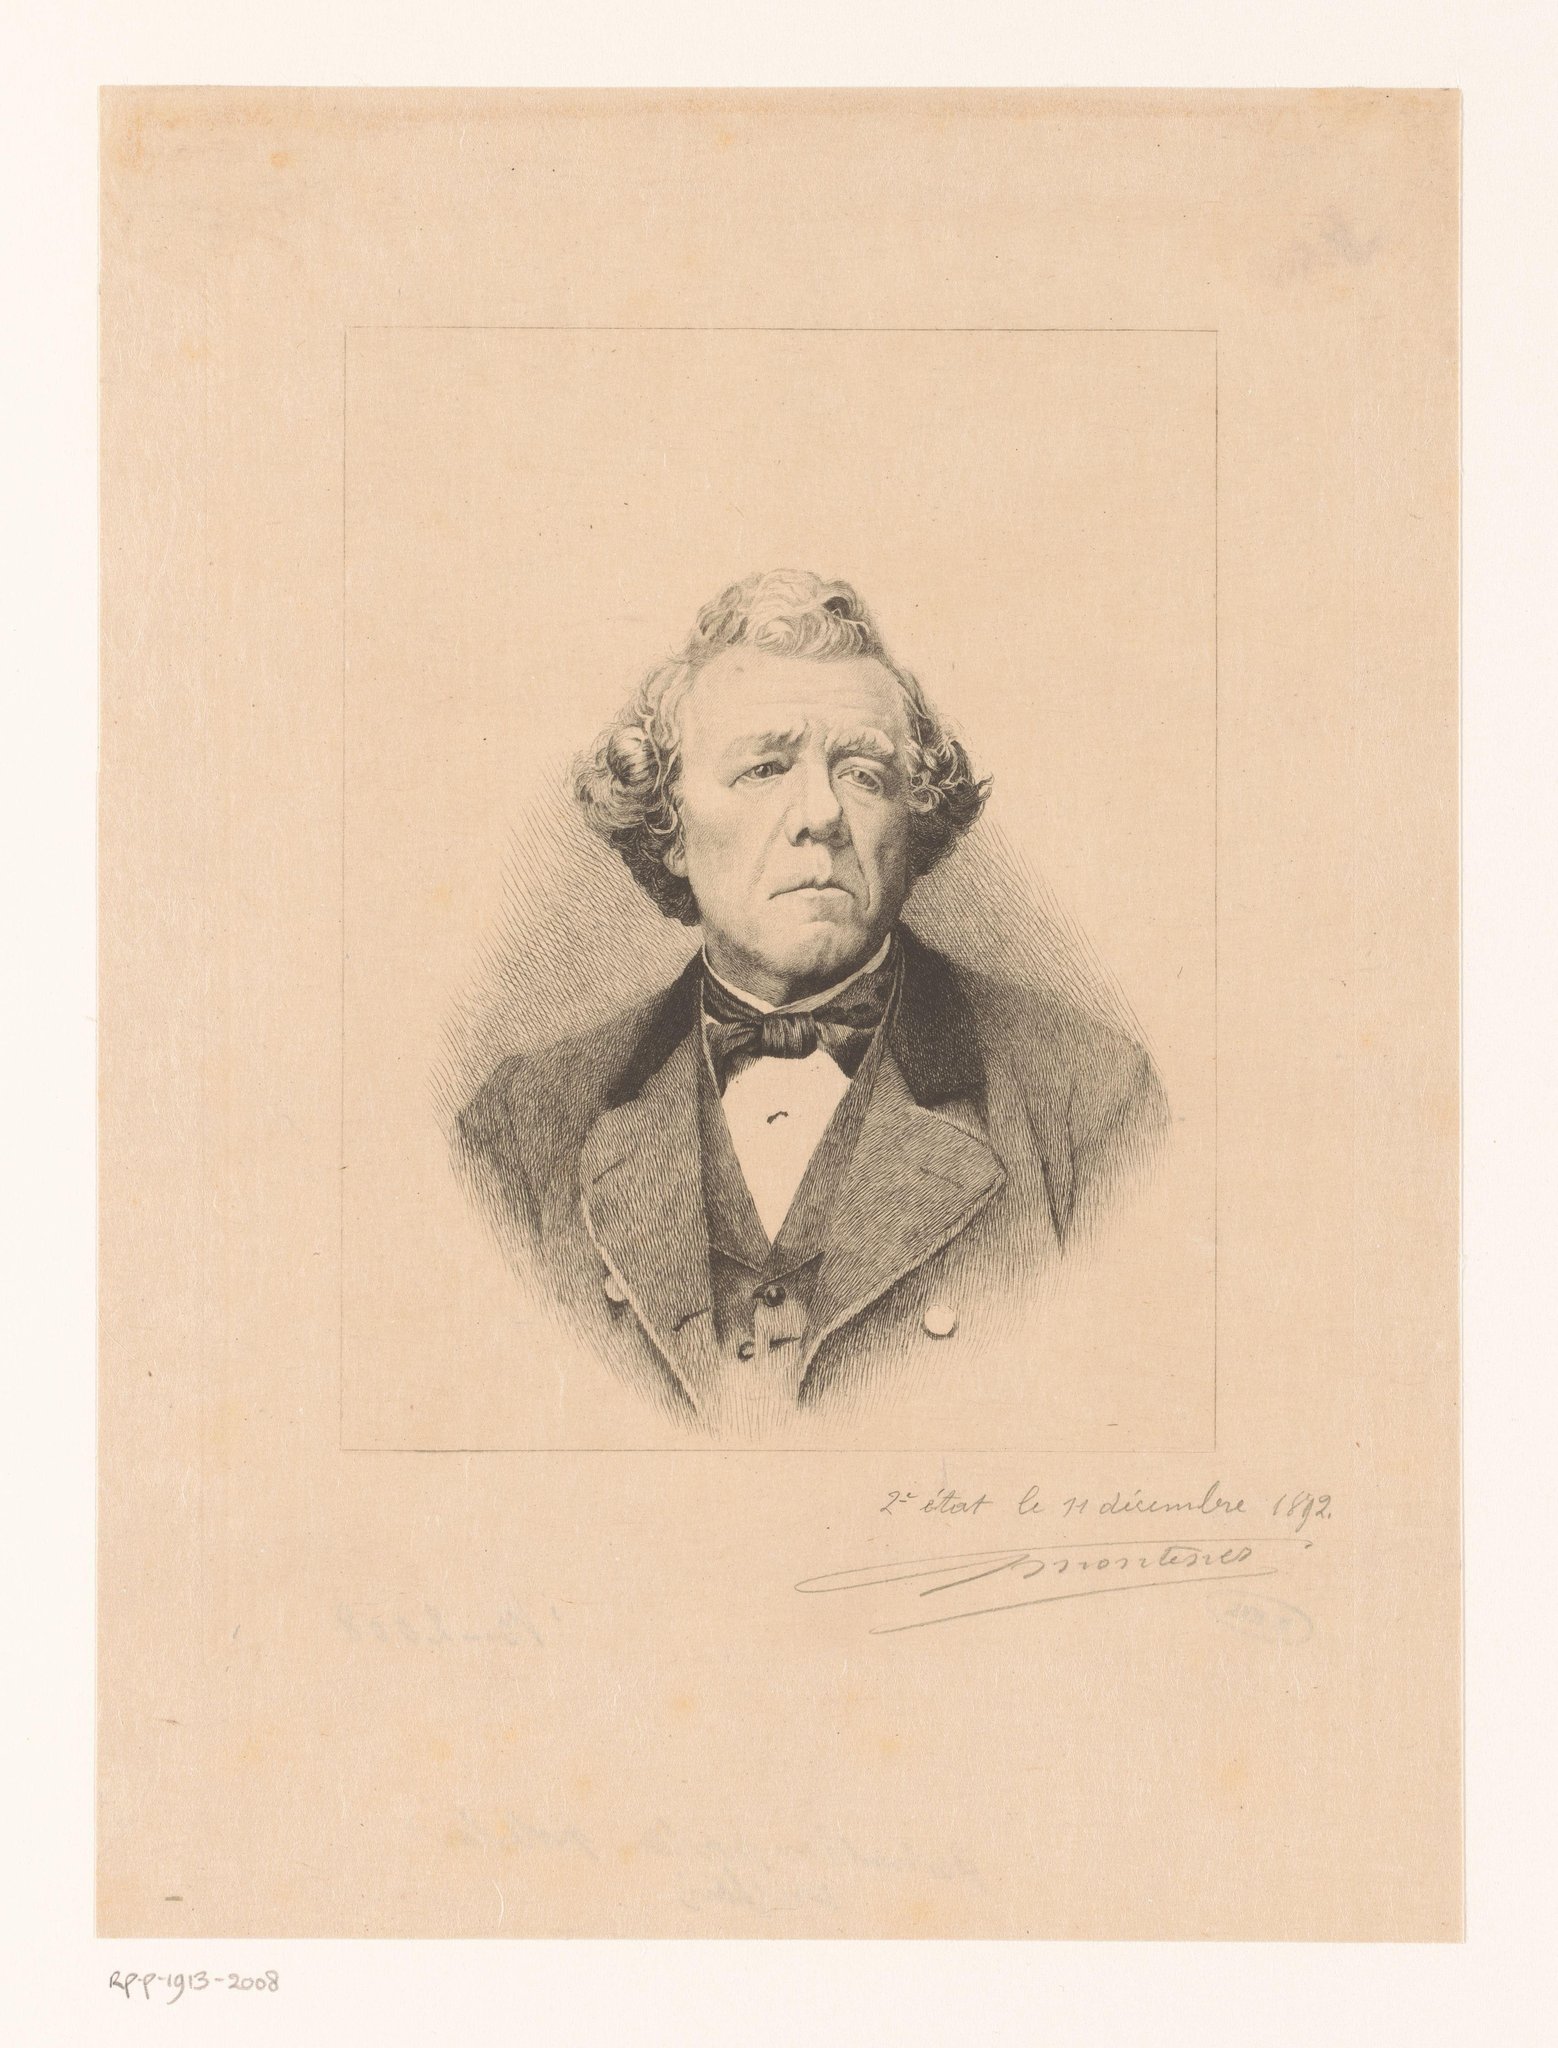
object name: print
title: Portret van een onbekende man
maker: georges montenez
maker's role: print maker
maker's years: 1873-1930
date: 1892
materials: paper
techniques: etching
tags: adult man, historical persons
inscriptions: inscription: ‘2e état le 11 décembre 1892’, inscription: ‘Portrait d un pasteur protestant anglais’, collector's mark: Lugt 2228